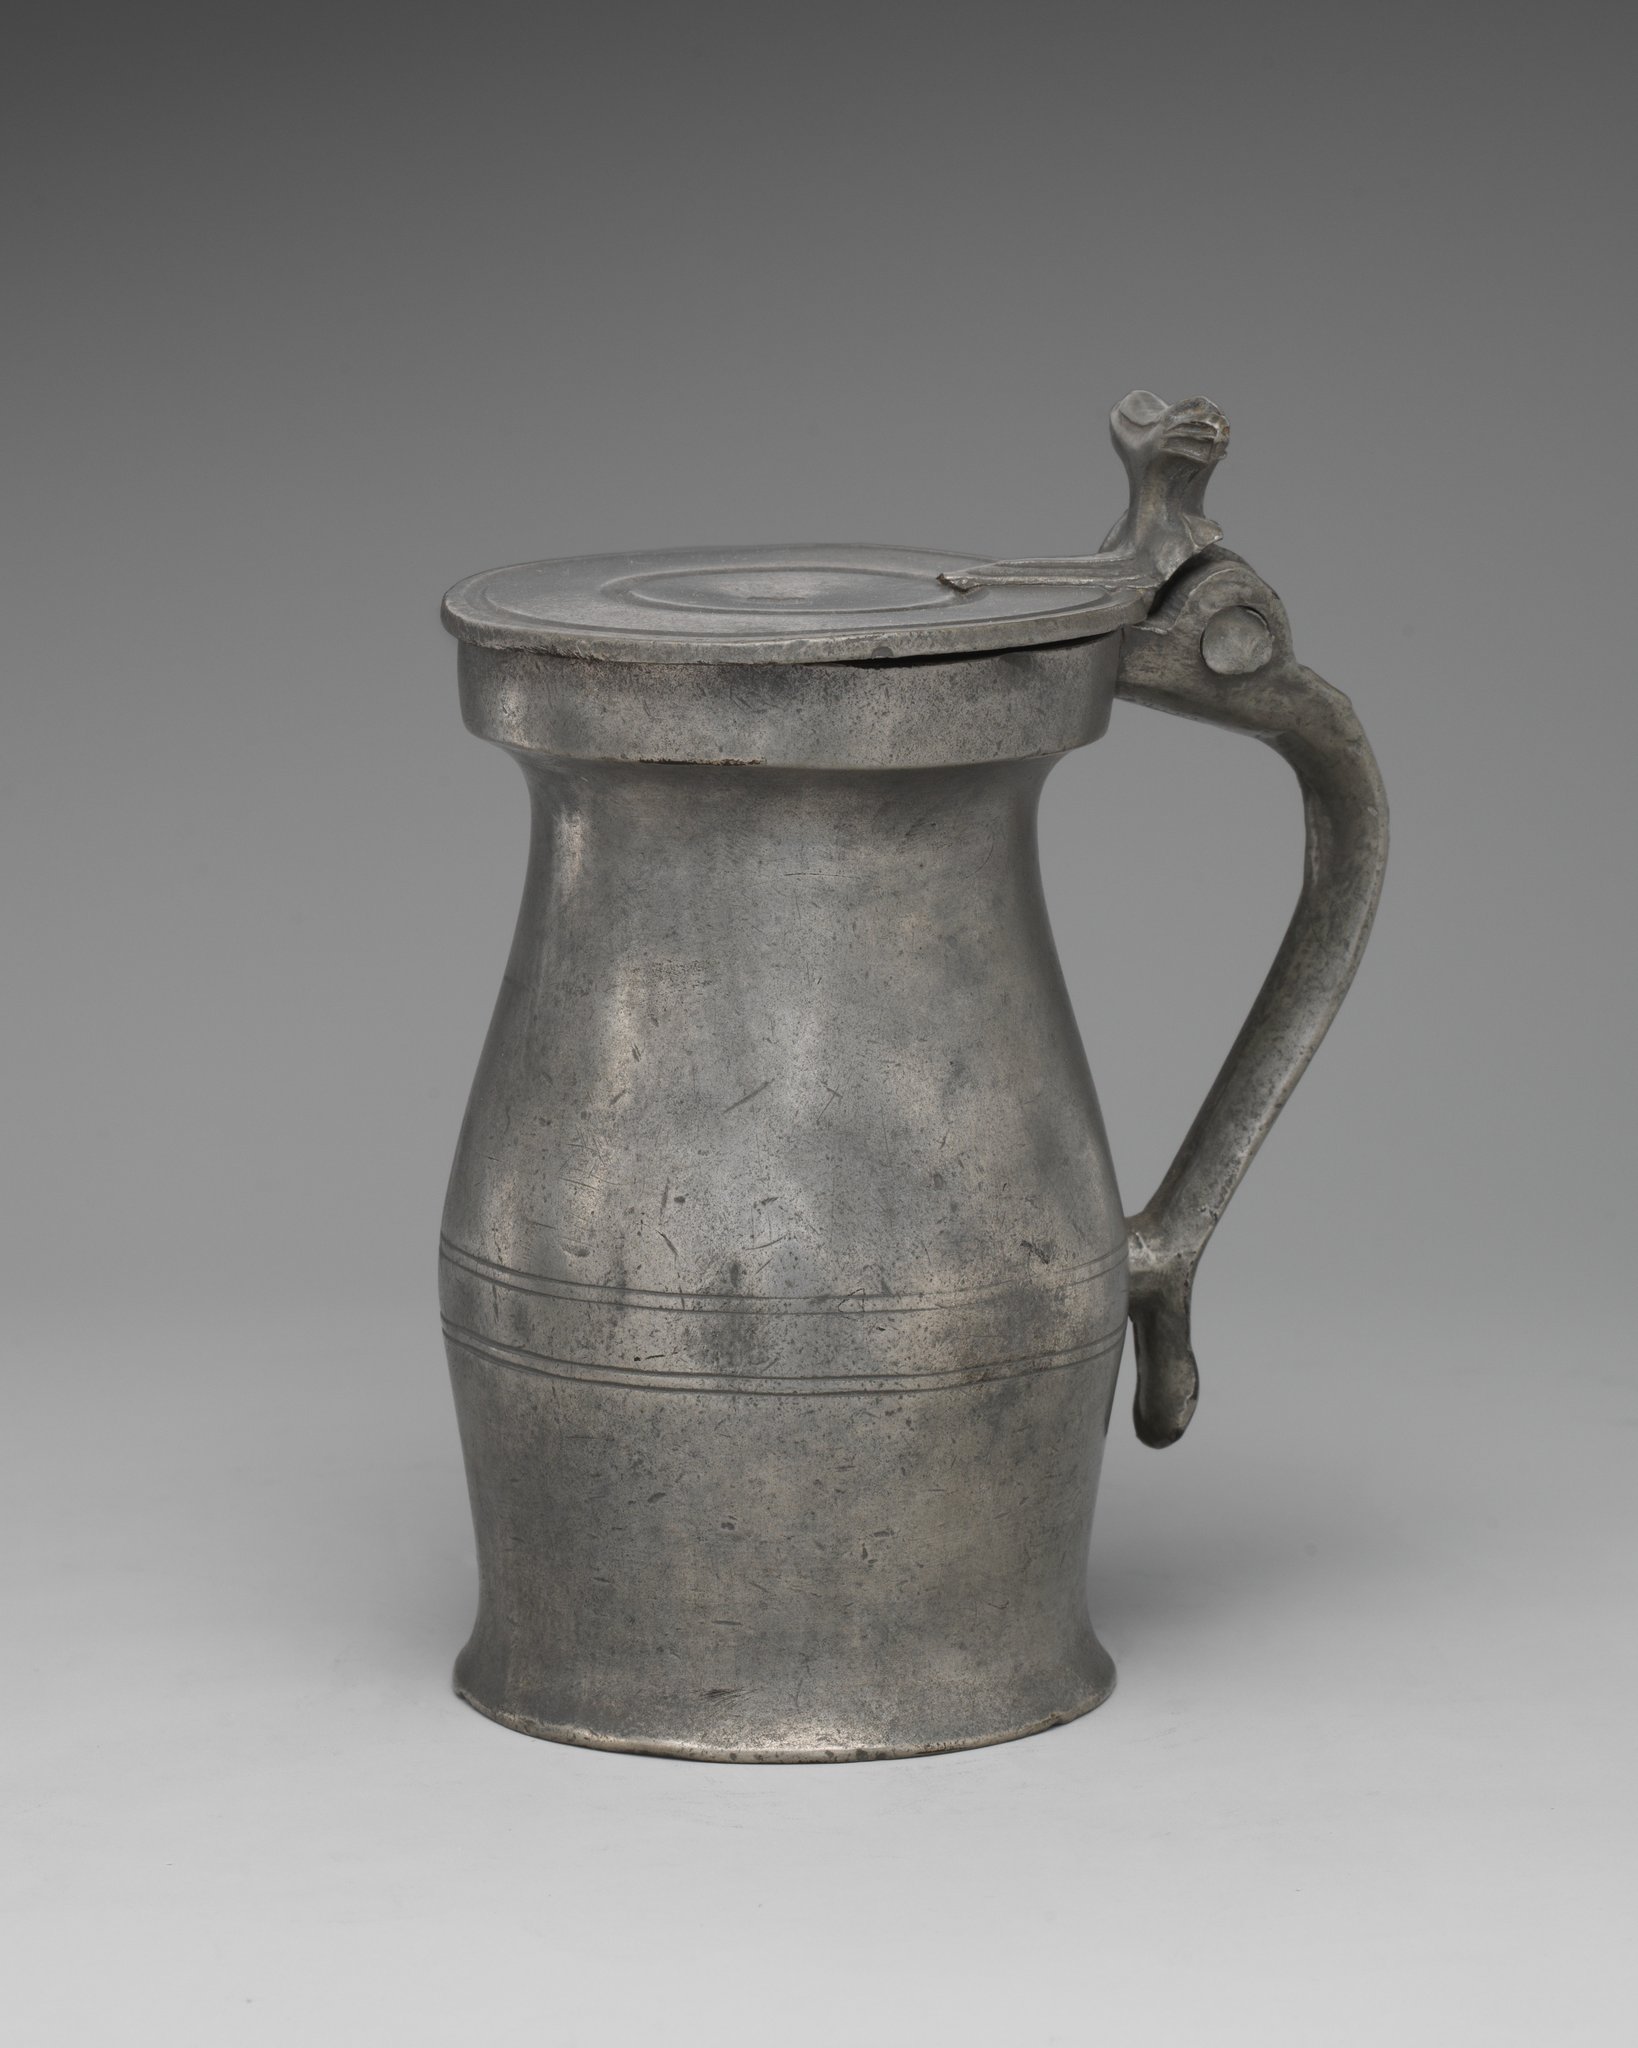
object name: measure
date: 1701-1800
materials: pewter